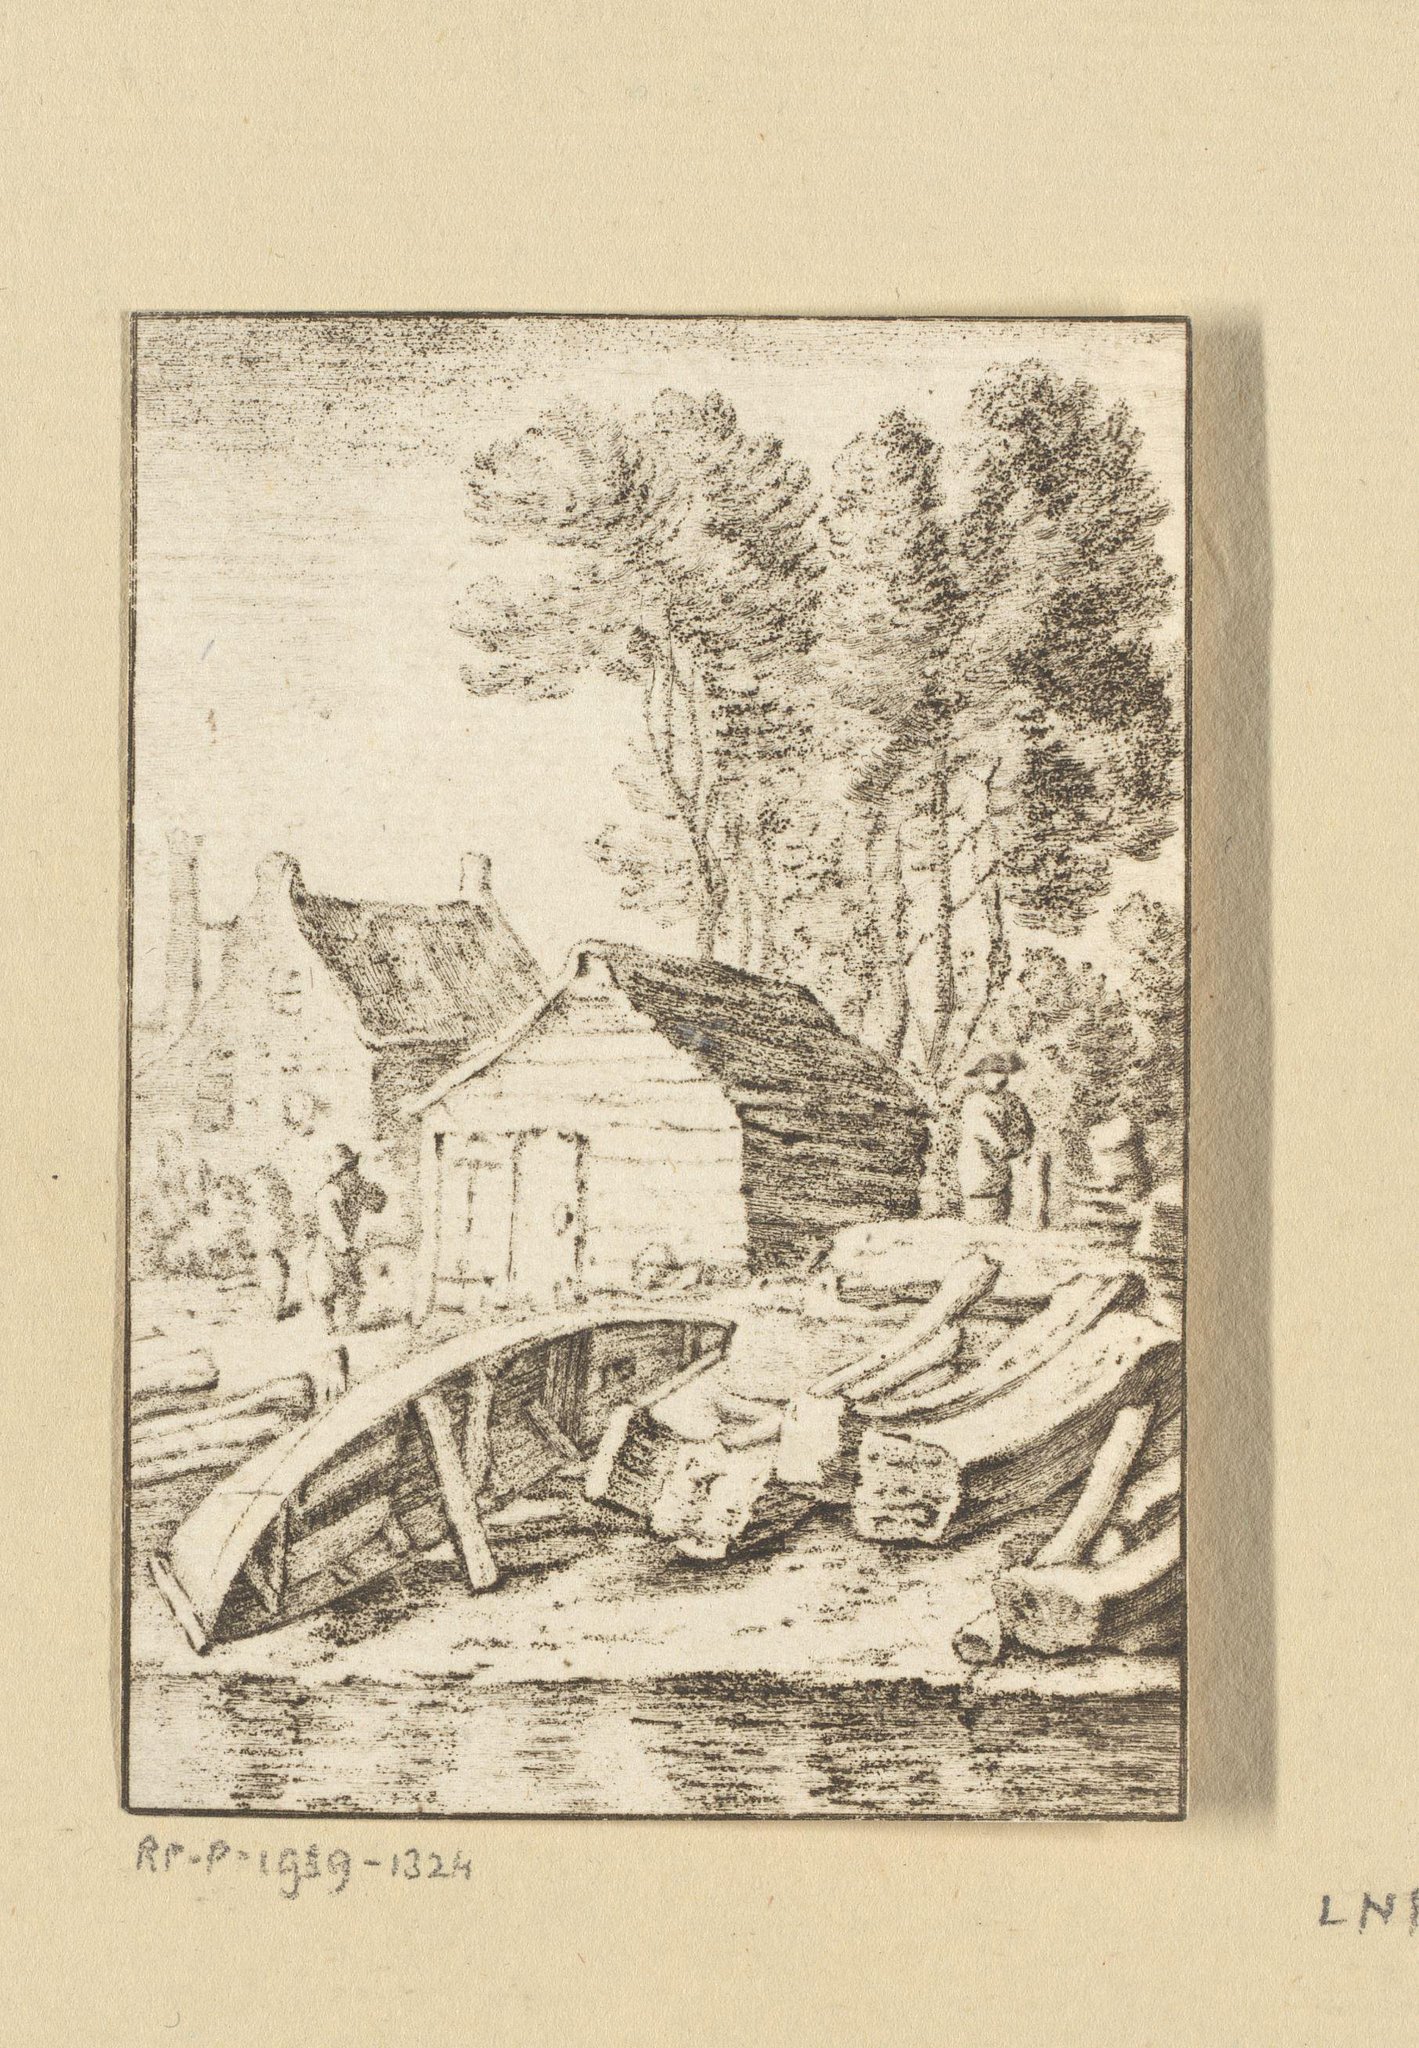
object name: print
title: Schuitenmakerswerf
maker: cornelis ploos van amstel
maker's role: draughtsman, print maker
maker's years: 1726-1798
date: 1761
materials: paper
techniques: printmaking, etching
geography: amsterdam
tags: shipyard, shipdock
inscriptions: collector's mark: Lugt 2725, collector's mark: ‘RIJKS / MUSM’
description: Een scheepswerf met enkele figuren, een huis en een schuur. De prent ligt los in een album, zie blad 2.